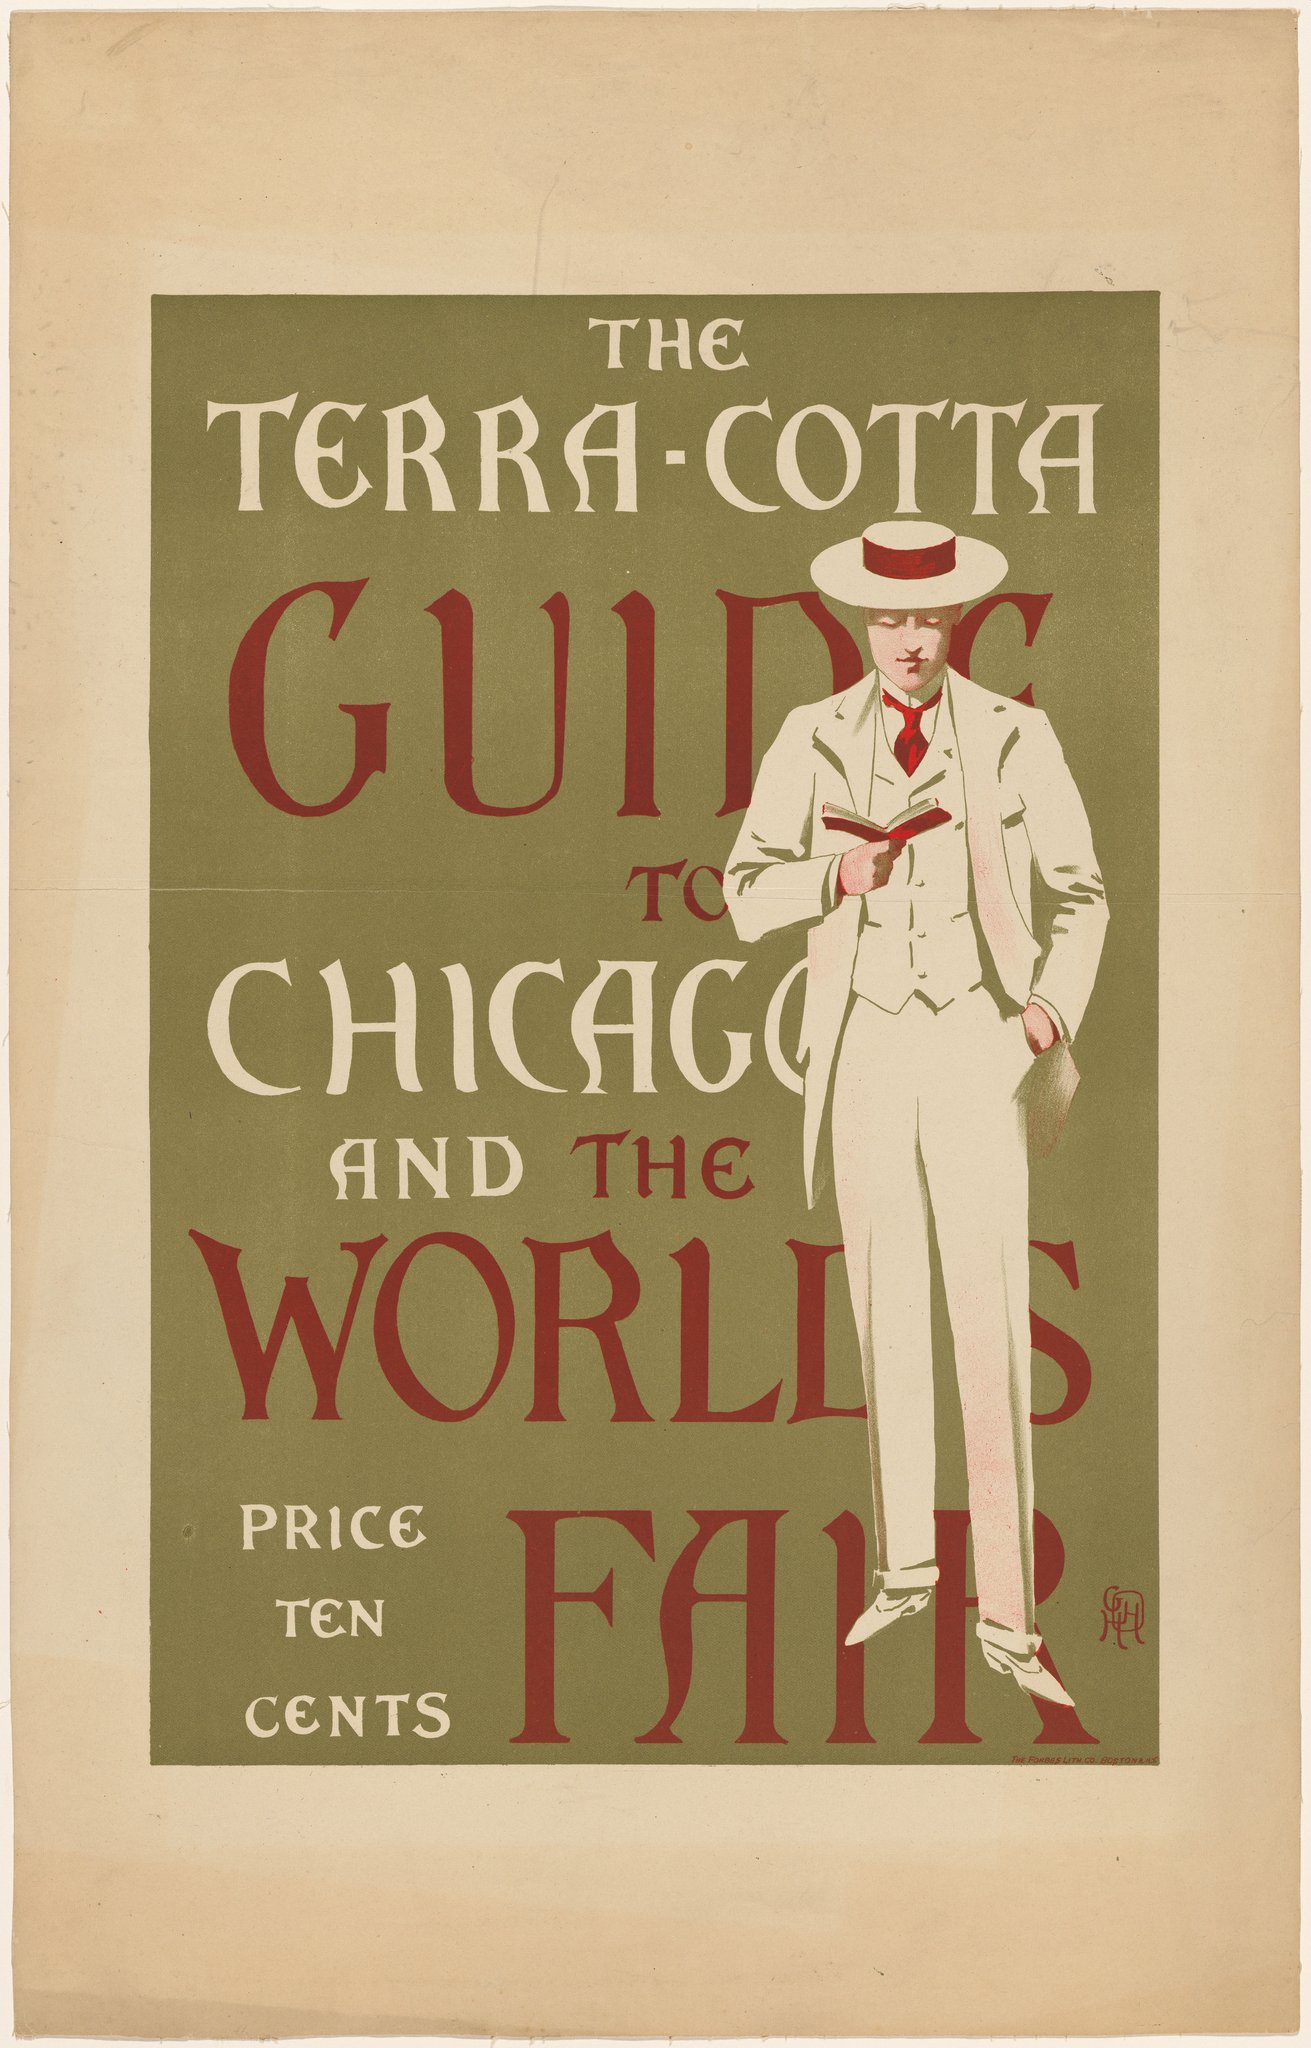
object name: poster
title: The Terra-Cotta Guide to Chicago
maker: g. h. h.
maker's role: artist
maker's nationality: american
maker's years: 1800-1900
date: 1893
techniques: lithograph